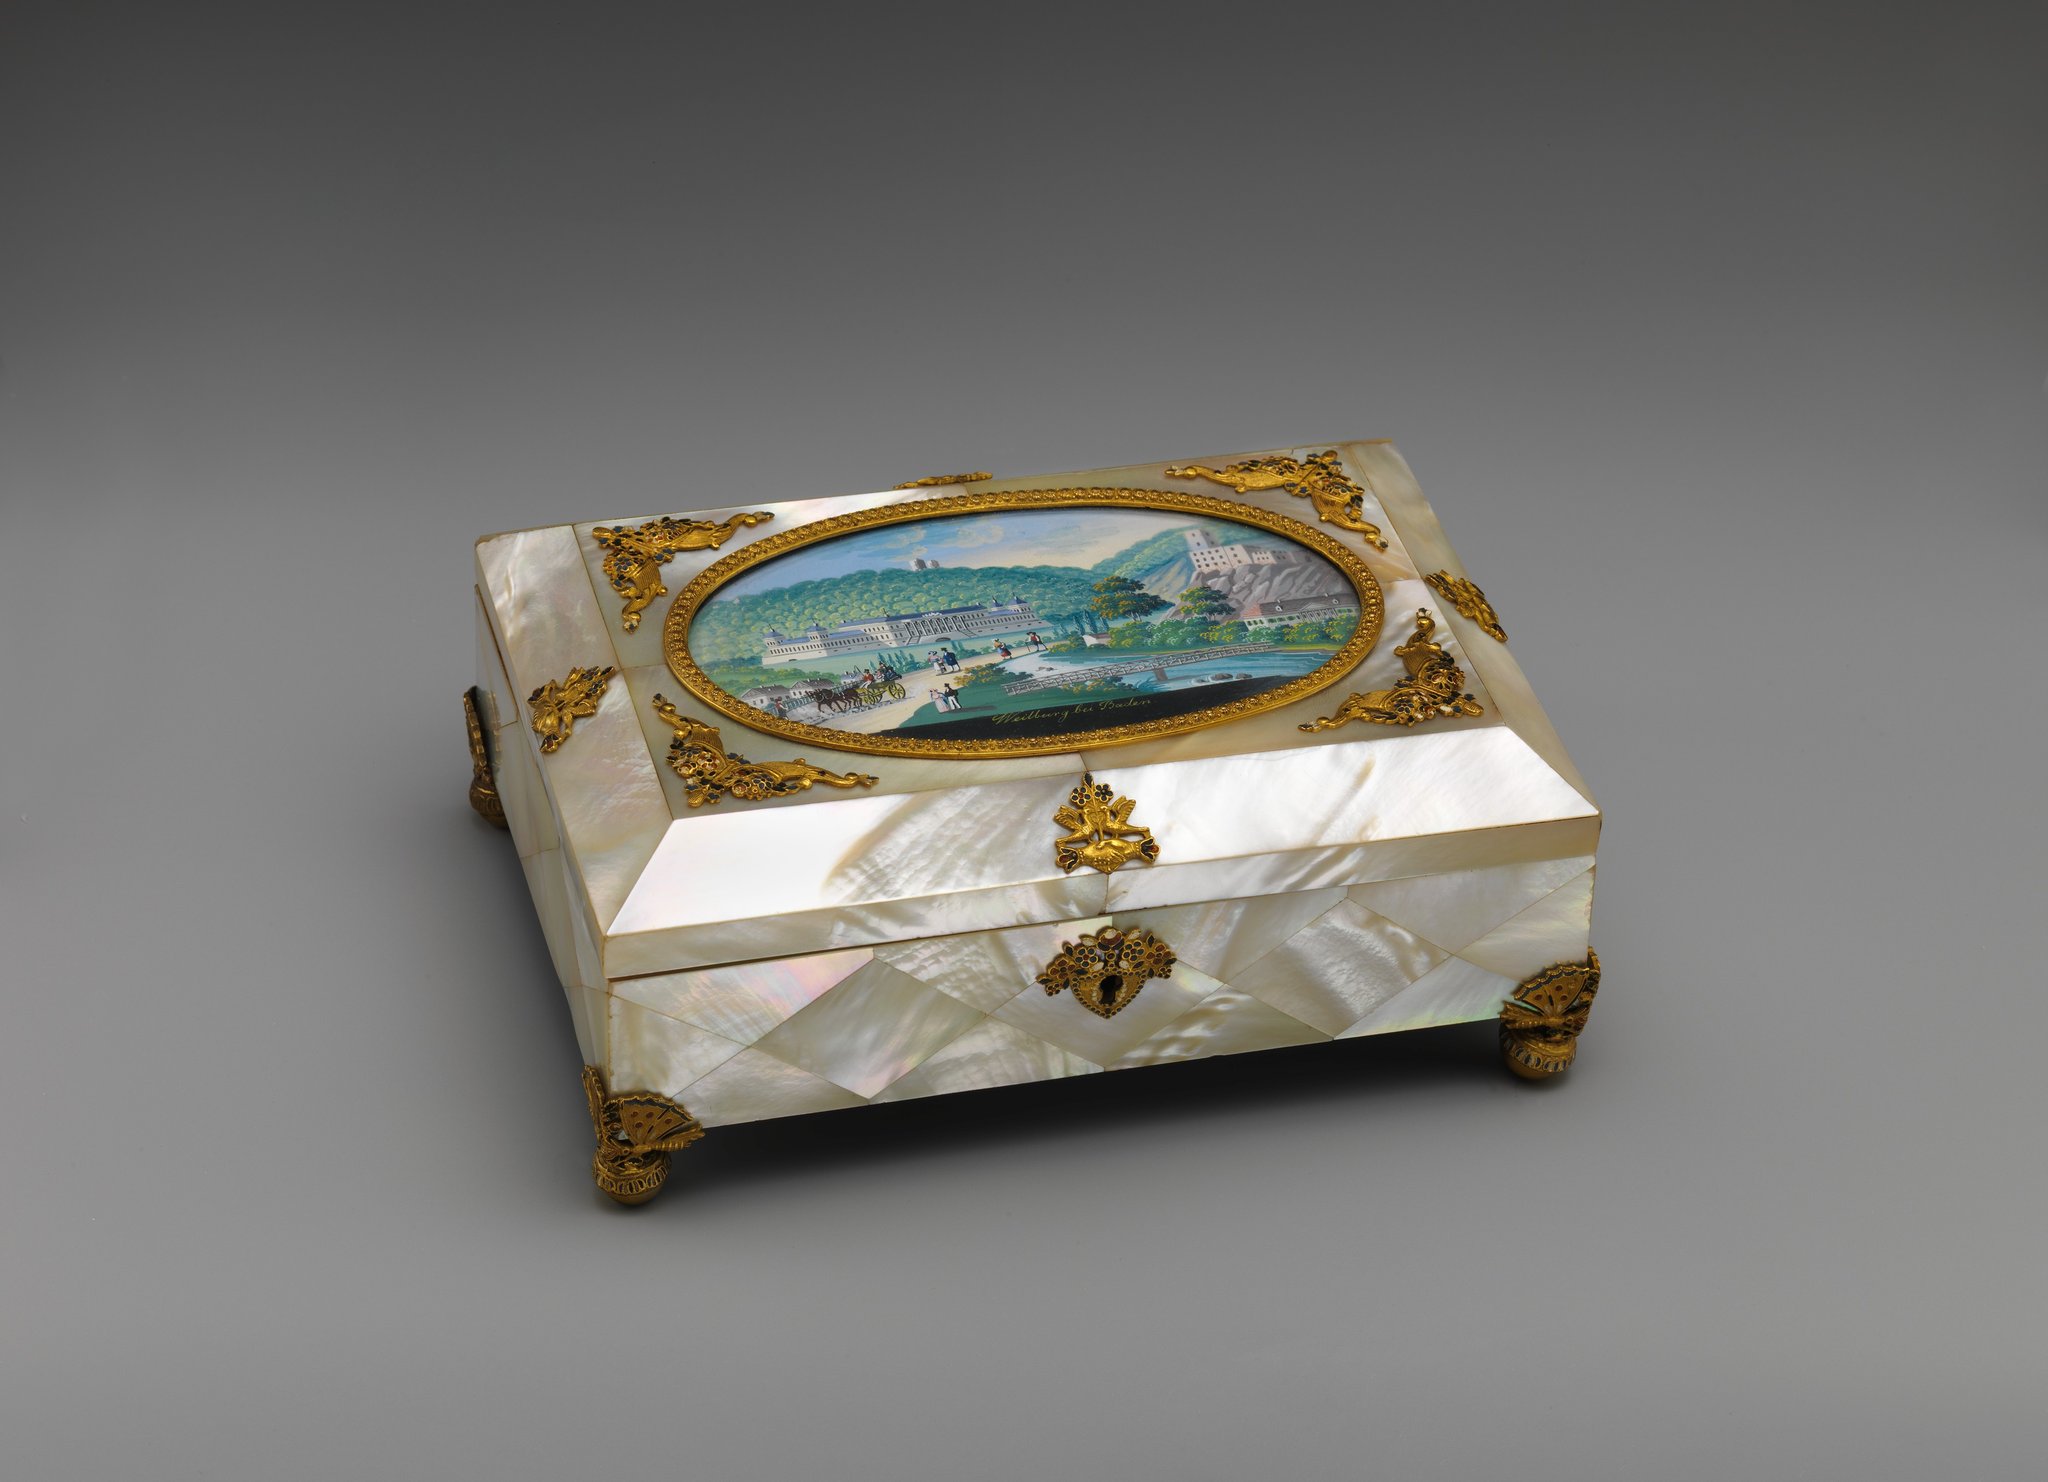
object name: sewing casket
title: Sewing casket with view of Weilburg near Baden in Austria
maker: balthasar wigand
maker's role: artist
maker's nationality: austrian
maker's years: 1771-1846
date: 1820-1830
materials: gilt, gouache, metal, mother of pearl, paper, steel, velvet, wood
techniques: enamel, lining, veneering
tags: cities,landscapes